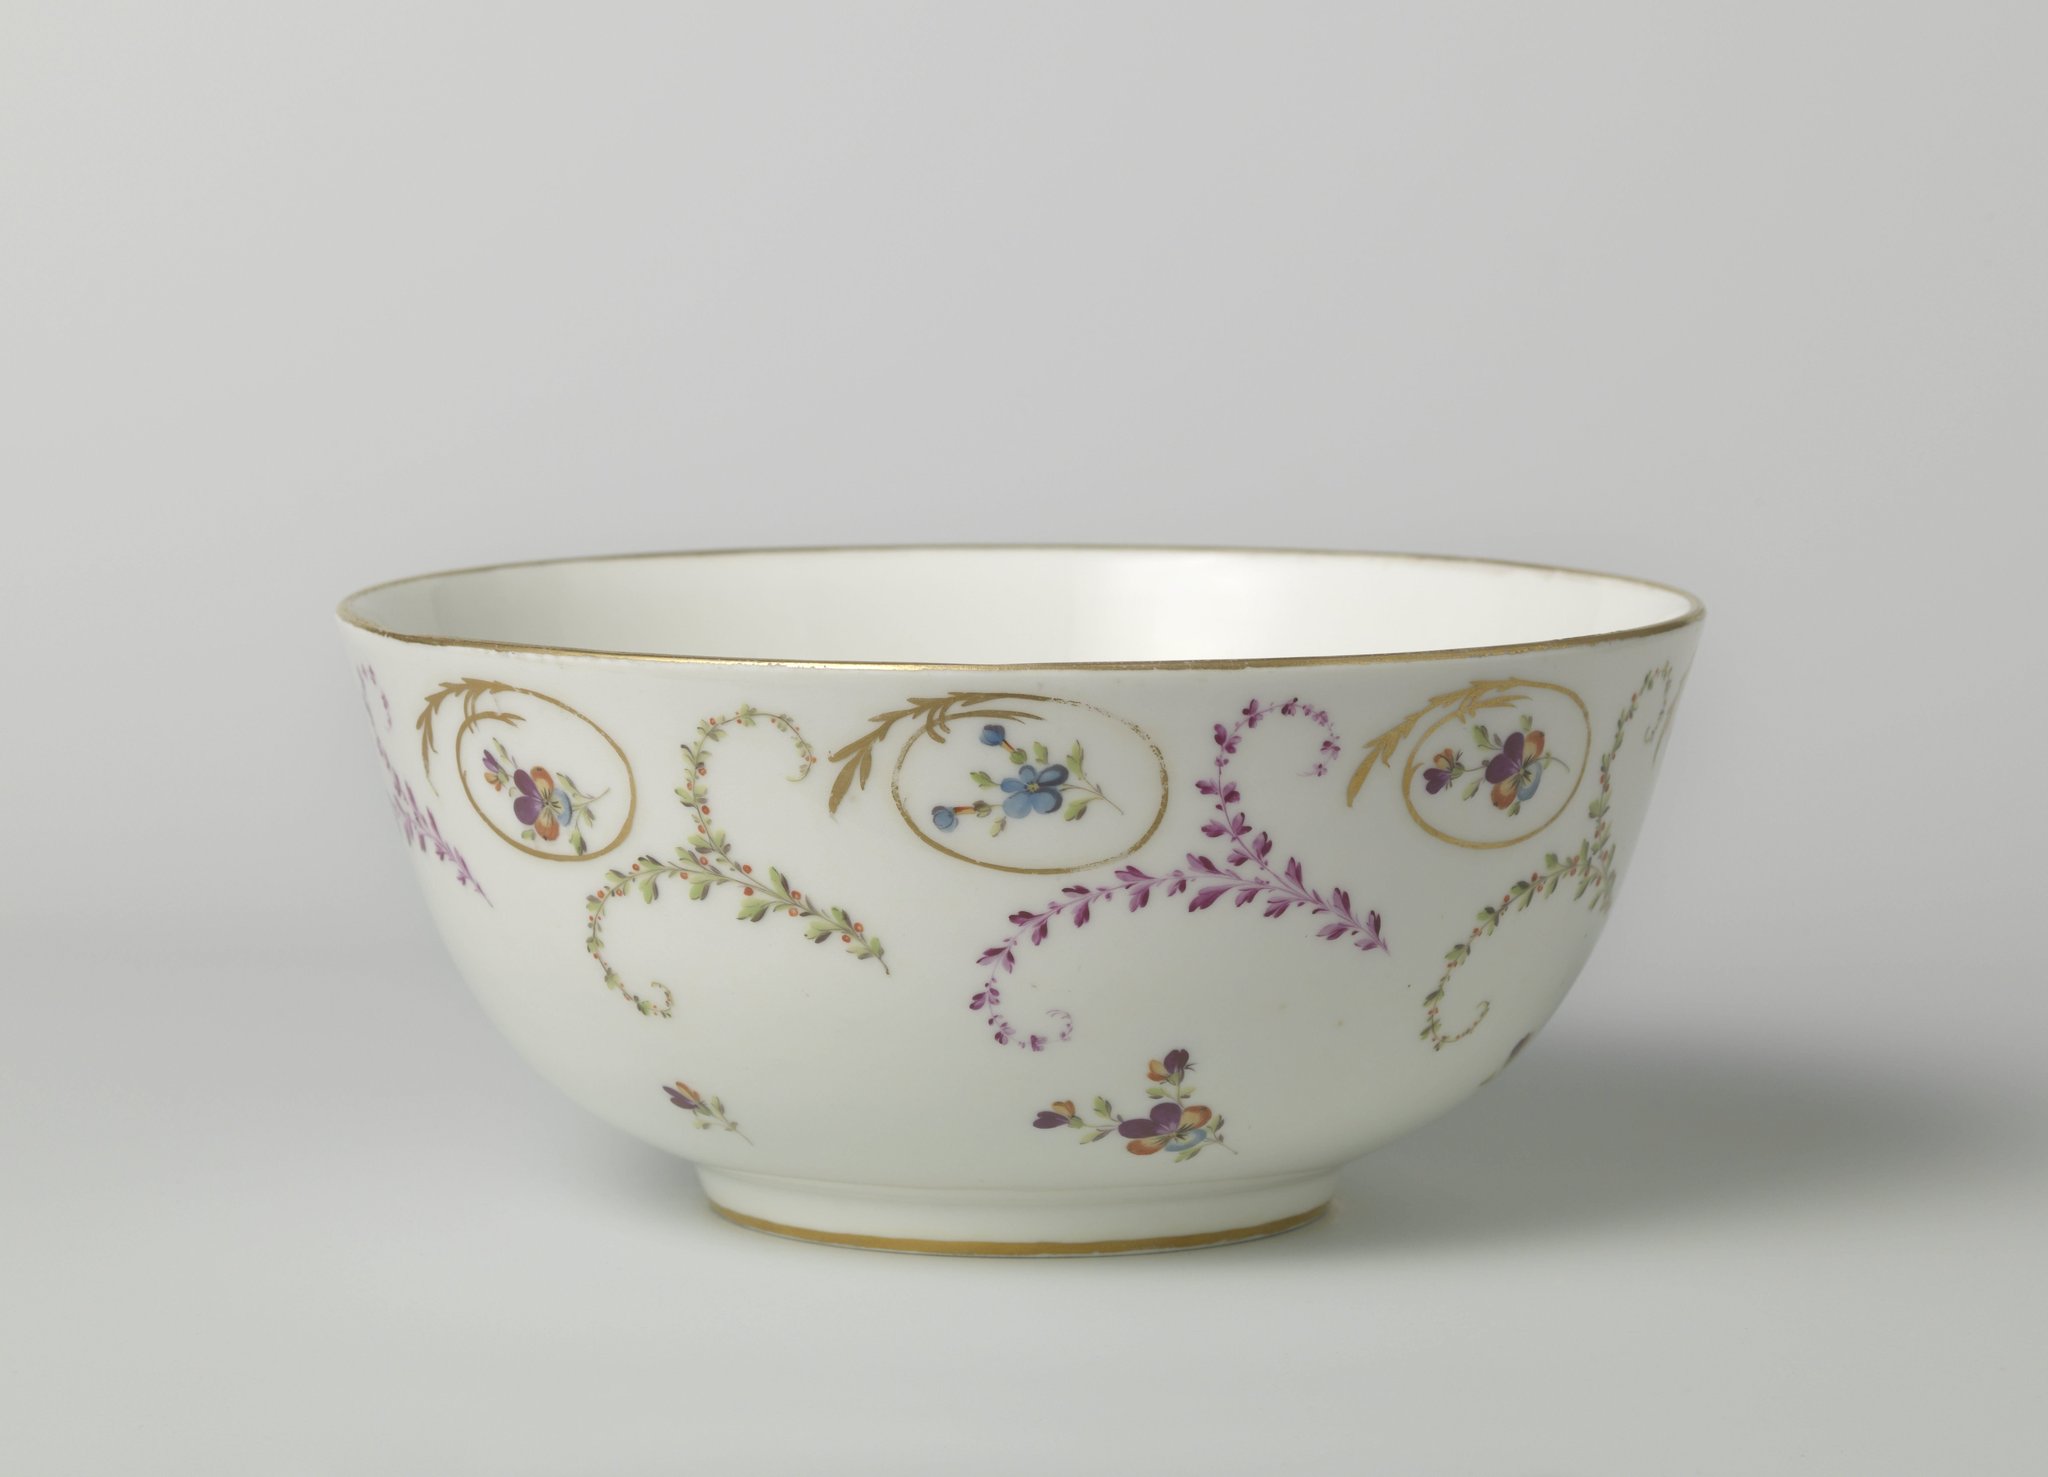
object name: slop bowl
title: Spoelkom, beschilderd met bladranken en voluten waarbinnen een bloem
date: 1784-1809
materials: porcelain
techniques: painted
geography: ouder-amstel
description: Spoelkom veelkleurig beschilderd met bladranken en voluten waarbinnen een bloem. Gemerkt: Amstel in blauw onder het glazuur.